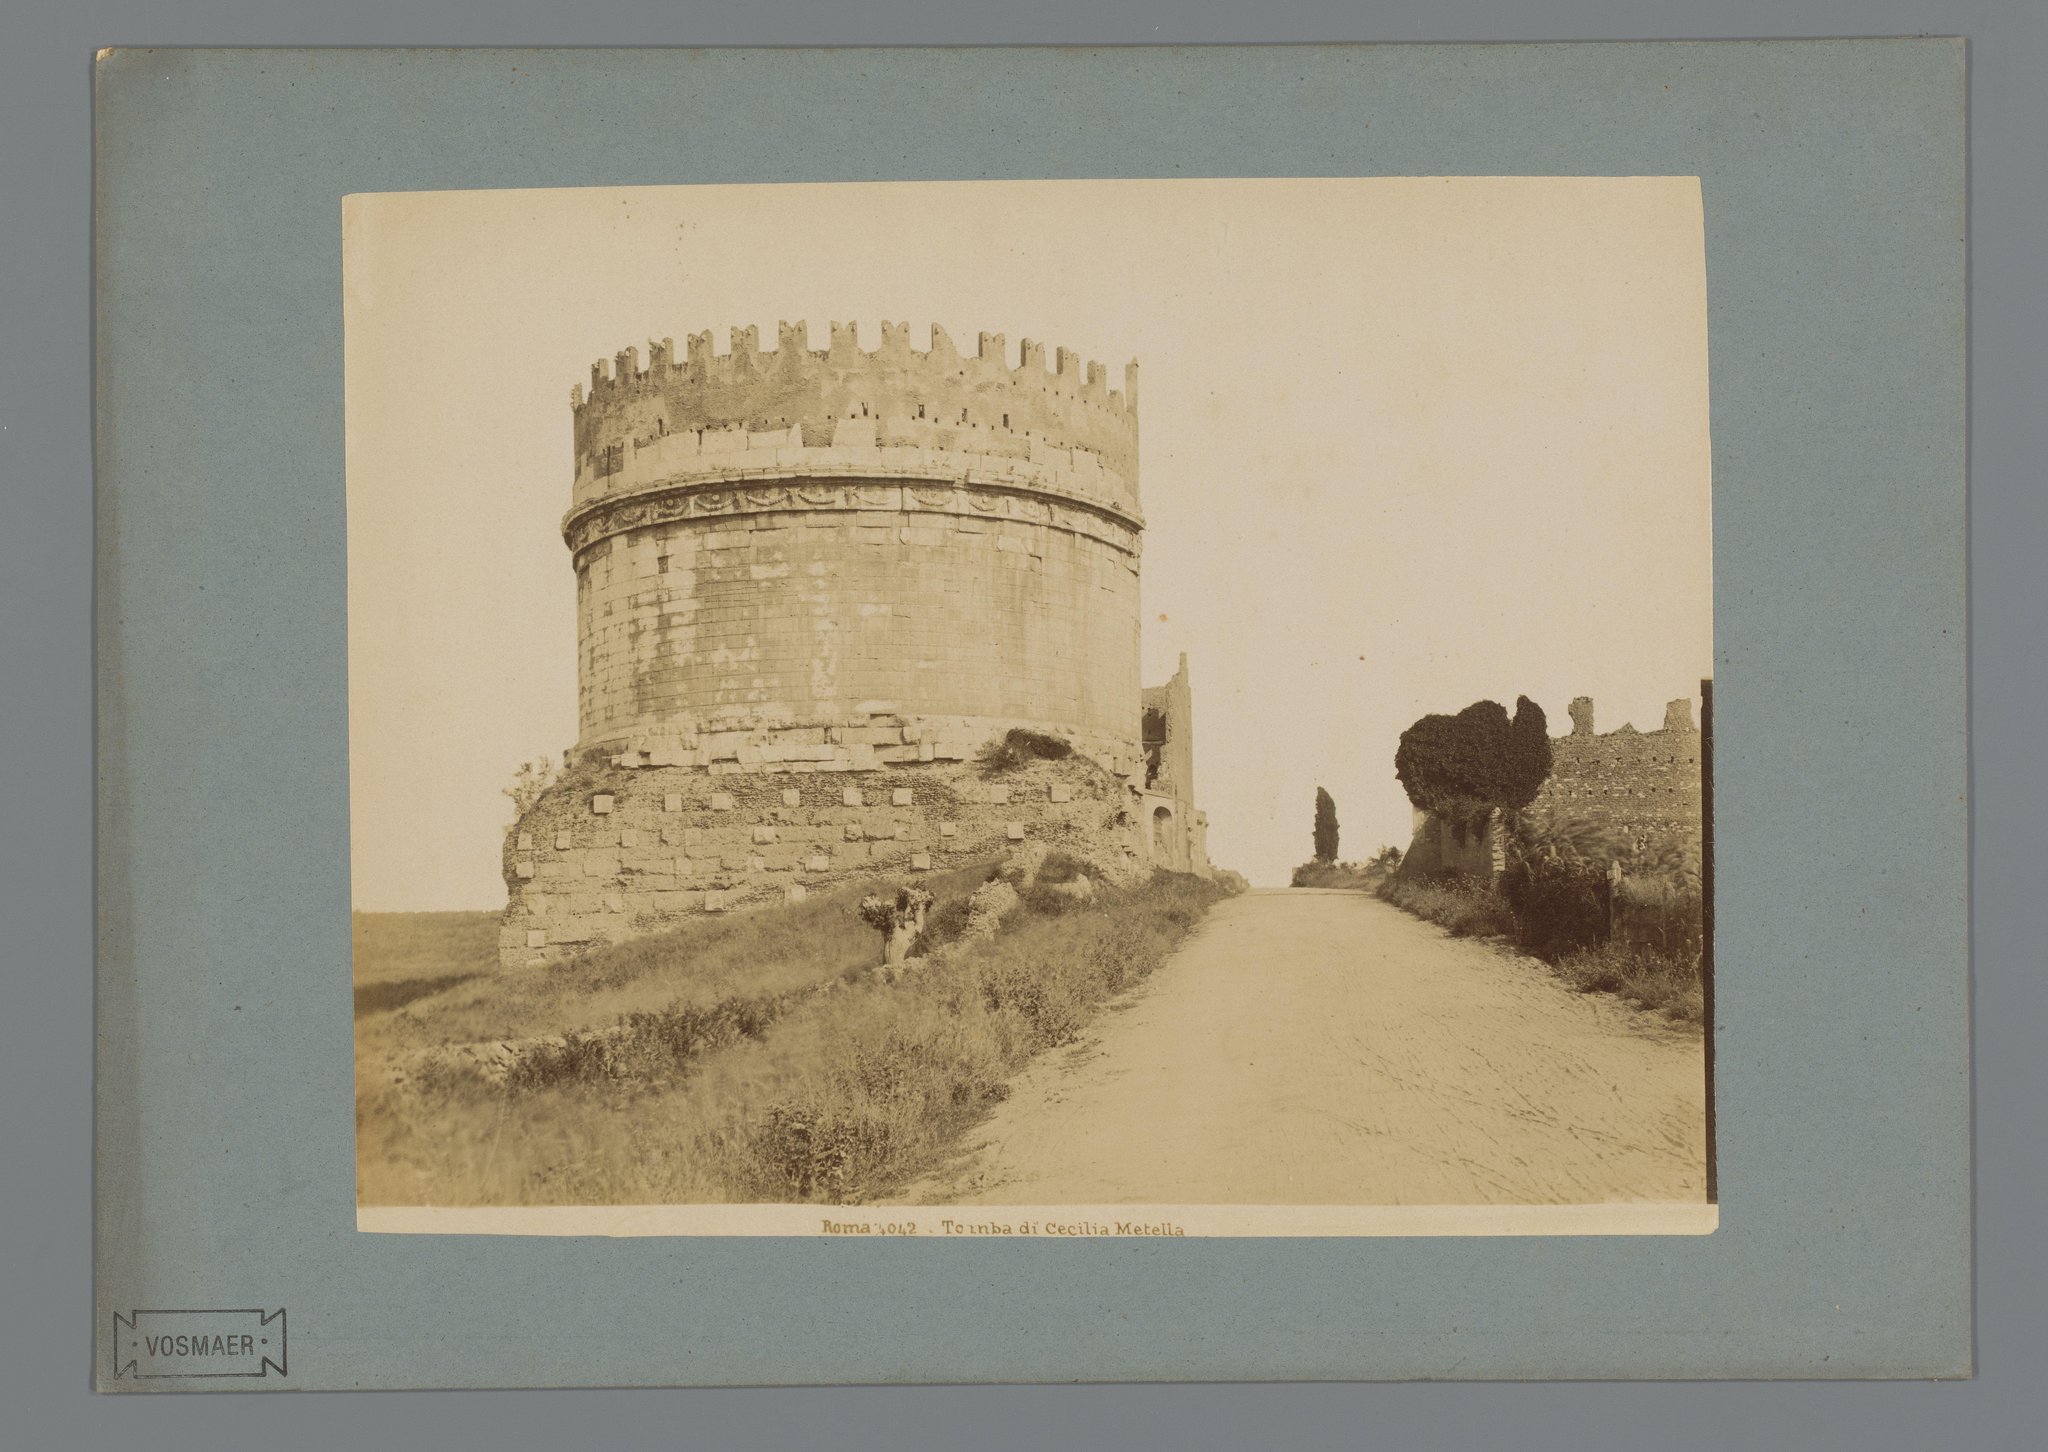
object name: photograph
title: Roma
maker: Anonymous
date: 1851-1890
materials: cardboard, paper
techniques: albumen print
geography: rome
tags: grave, tomb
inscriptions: collector's mark: ‘VOSMAER’, number: ‘4042’